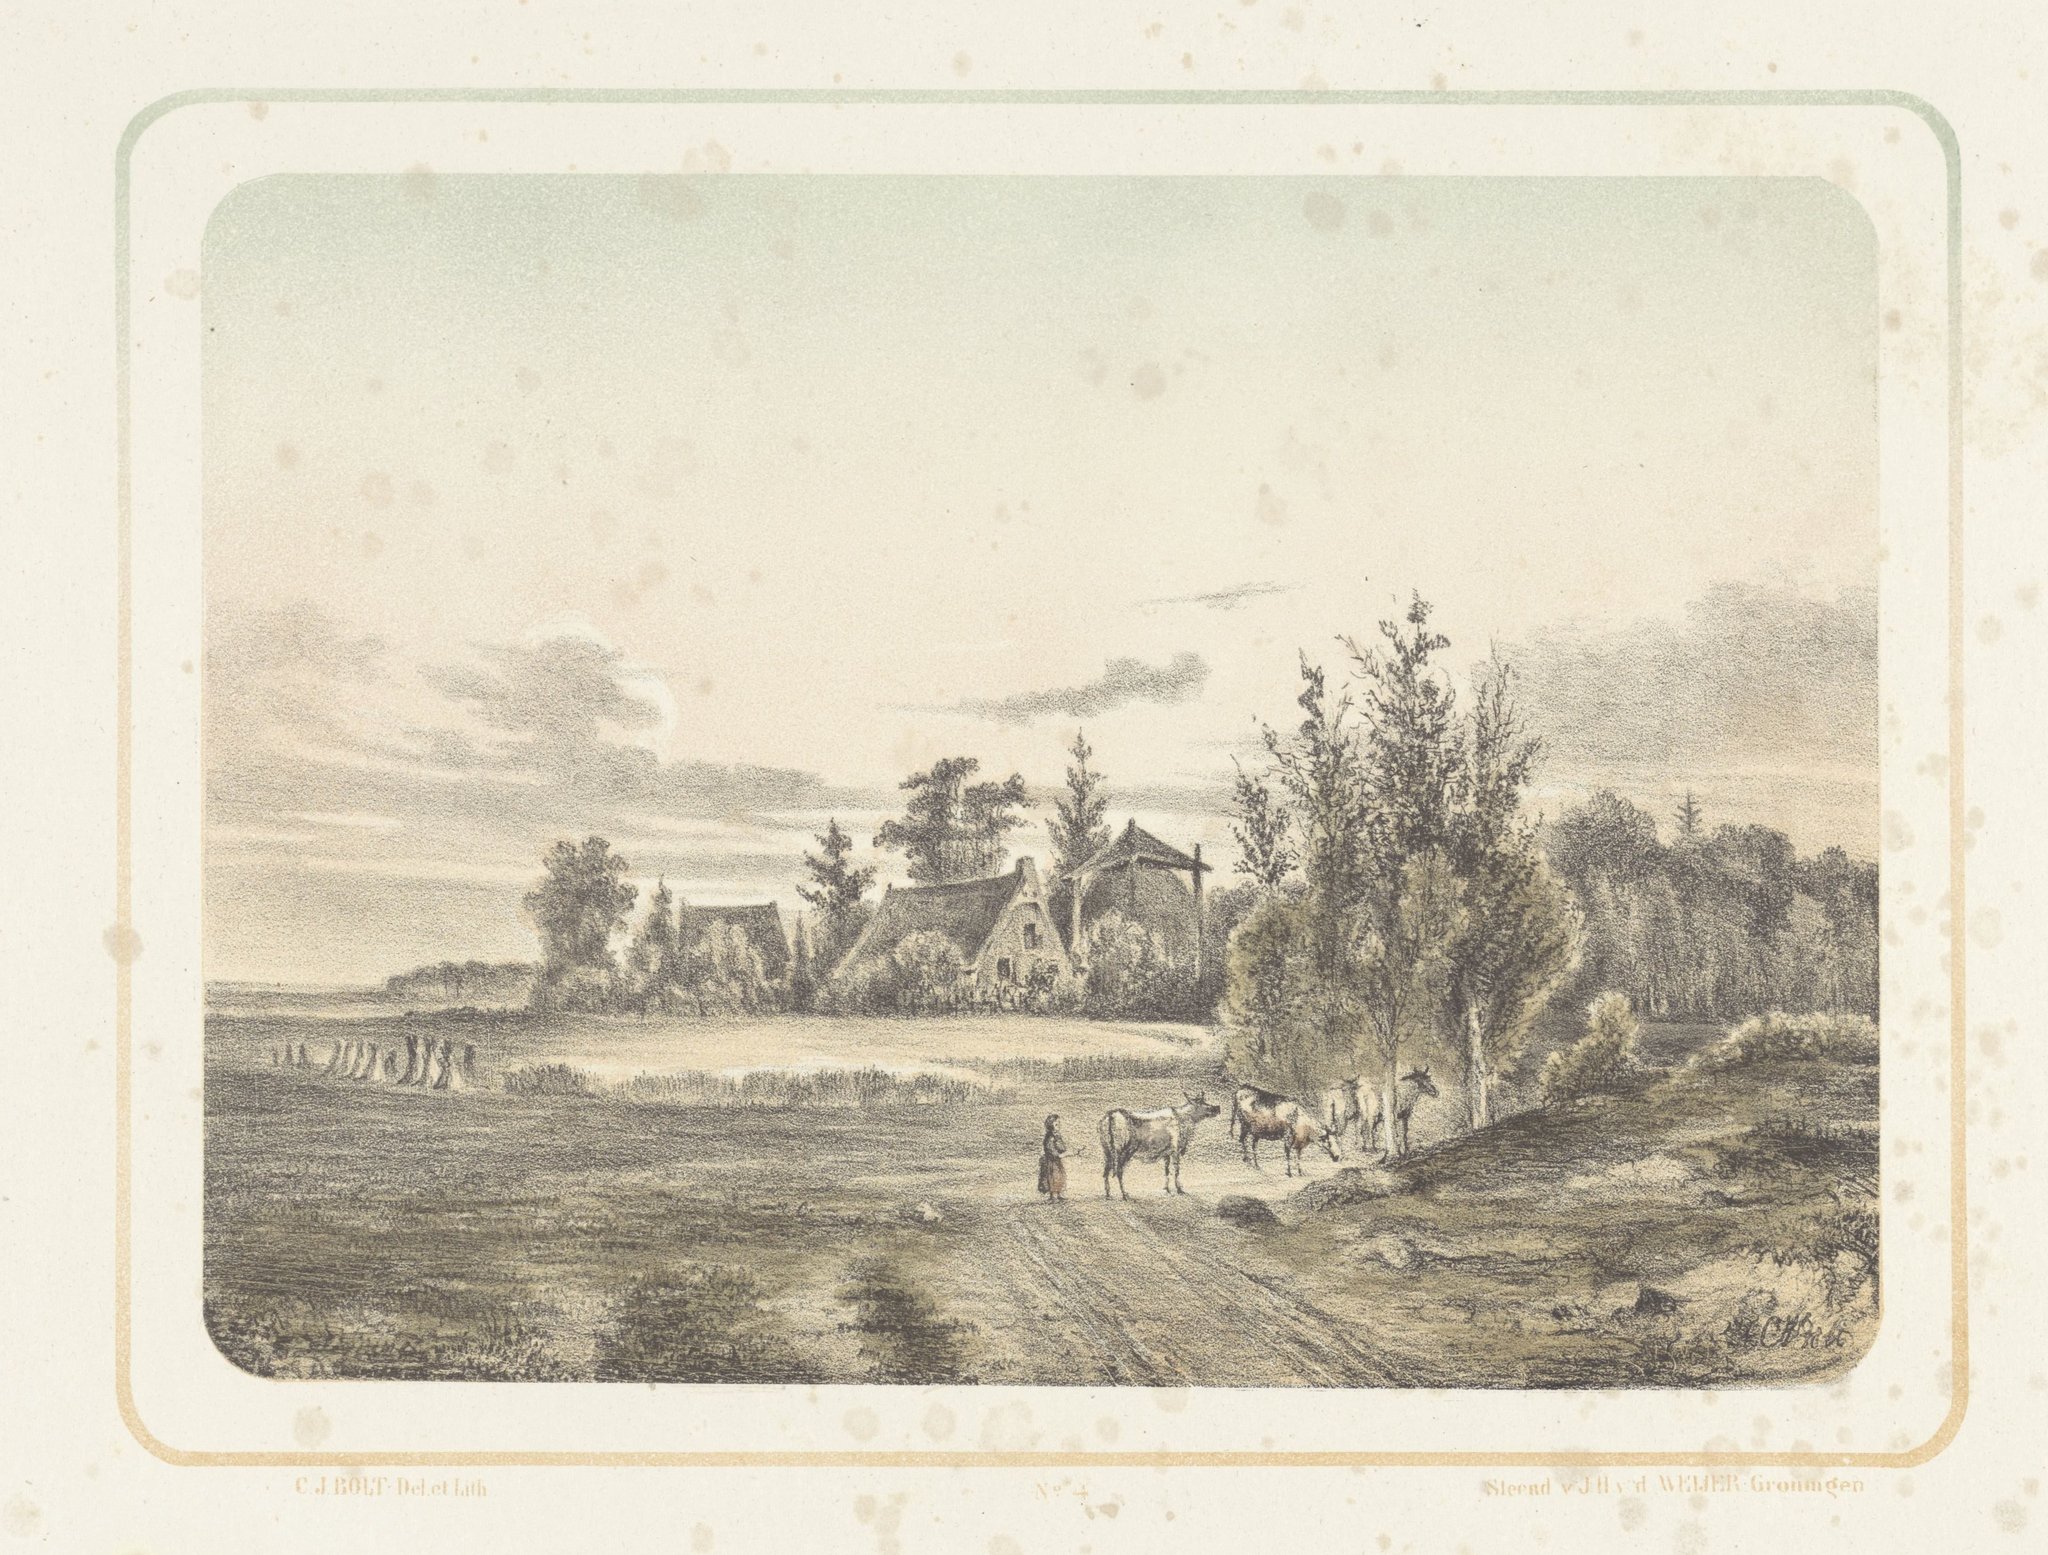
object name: print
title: Landschap met boerin en koeien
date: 1833-1879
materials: paper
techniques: lithograph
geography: netherlands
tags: cow, herding, herdsman, herdswoman, shepherd, shepherdess, cowherd, etc., sheaf, farm or solitary house in landscape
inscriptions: collector's mark: Lugt 2228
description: De boerin loopt achter haar koeien over een landweg richting de boerderij. In het veld staan schoven graan of stro. Bij de boederij staat een tot het dak gevulde stroschuur. Midden onder de afbeelding staat: no. 4.